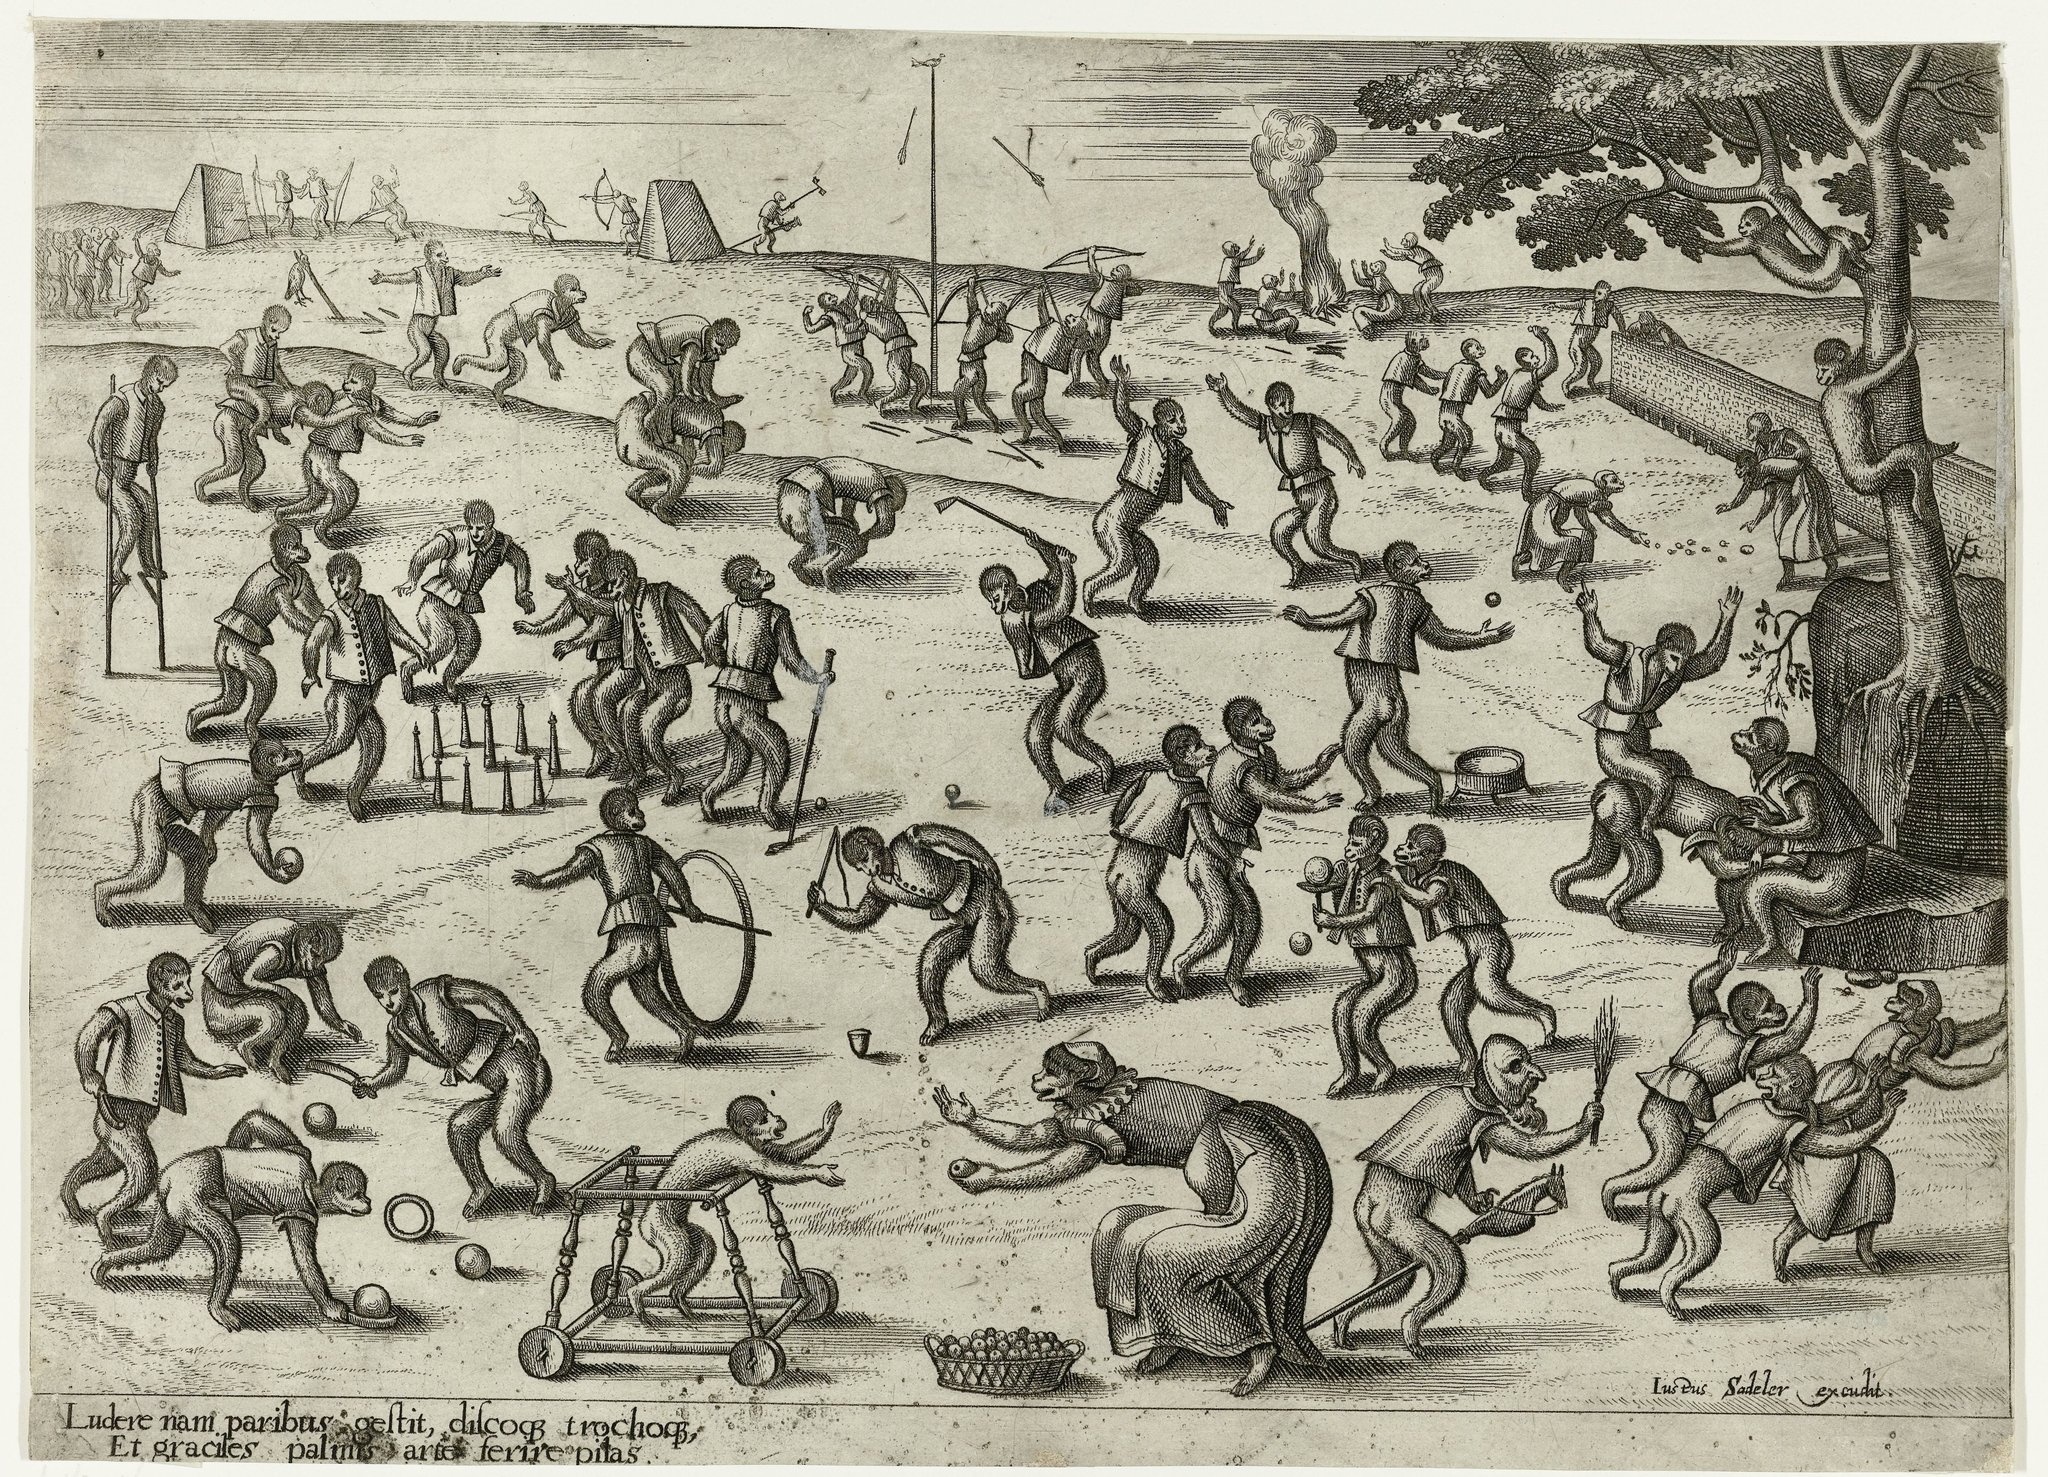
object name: print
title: Kinderspelen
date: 1593-1608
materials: paper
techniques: etching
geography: antwerp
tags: draughtsman, pieter bruegel (i), children's games and plays, monkeys, apes, 'mundus inversus', the reversed world, the topsy-turvy world, 'le monde bestourné'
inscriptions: collector's mark: Lugt 2228, collector's mark: Lugt 318, number: ‘3429’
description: In een open veld zijn apen aan het sporten en spelen. We zien jonge apen kegelen, hoepelen, knikkeren, boomklimmen, stokpaardje rijden, golfen, steltlopen, tollen, bokspringen, boogschieten en nog veel meer. Met onderschrift van twee regels in het Latijn.